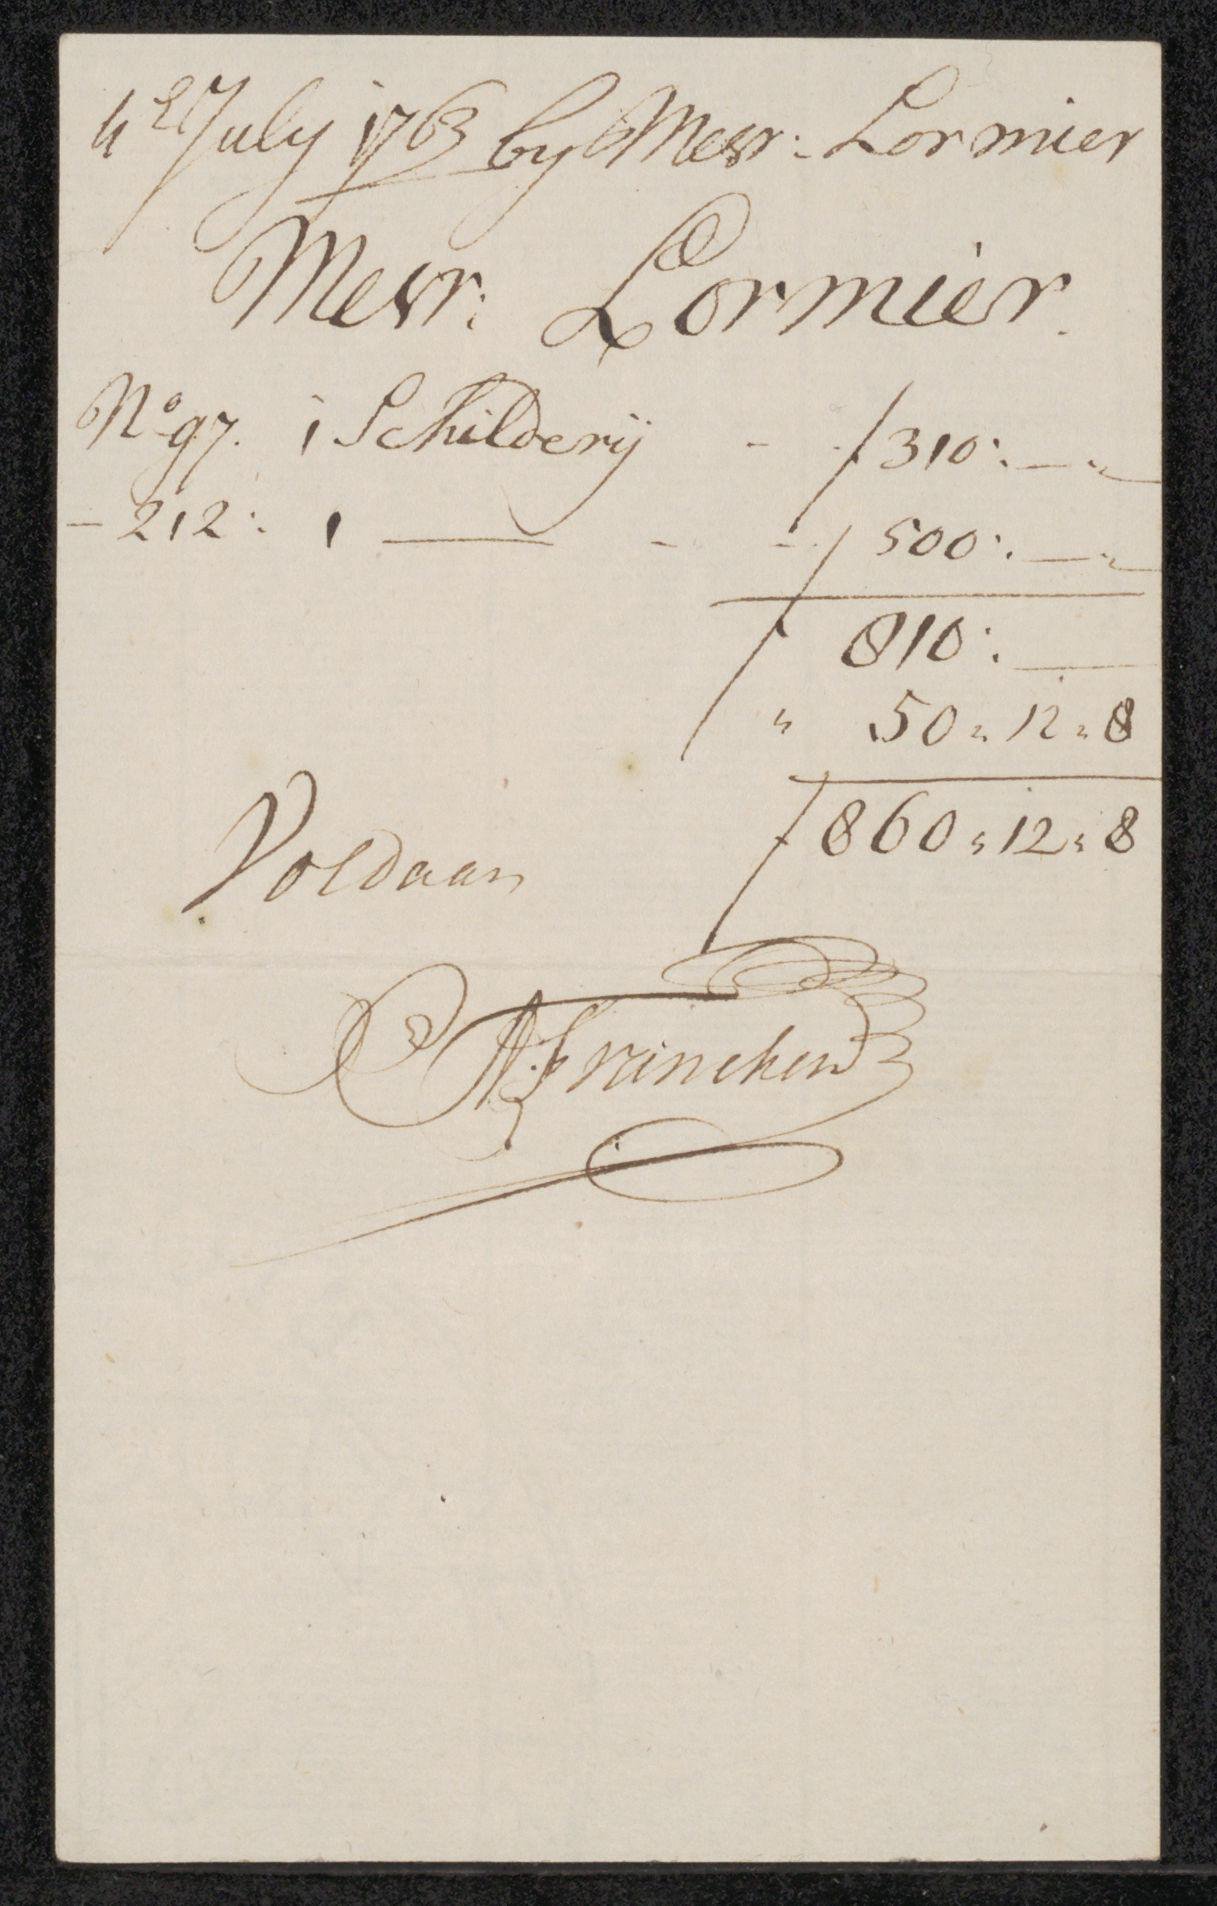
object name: ontvangstbewijs, kwitantie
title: Kwitantie voor onbekend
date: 1763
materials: ink, paper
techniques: pen, writing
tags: willem lormier, painting (including book-illumination, miniature-painting), money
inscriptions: watermark